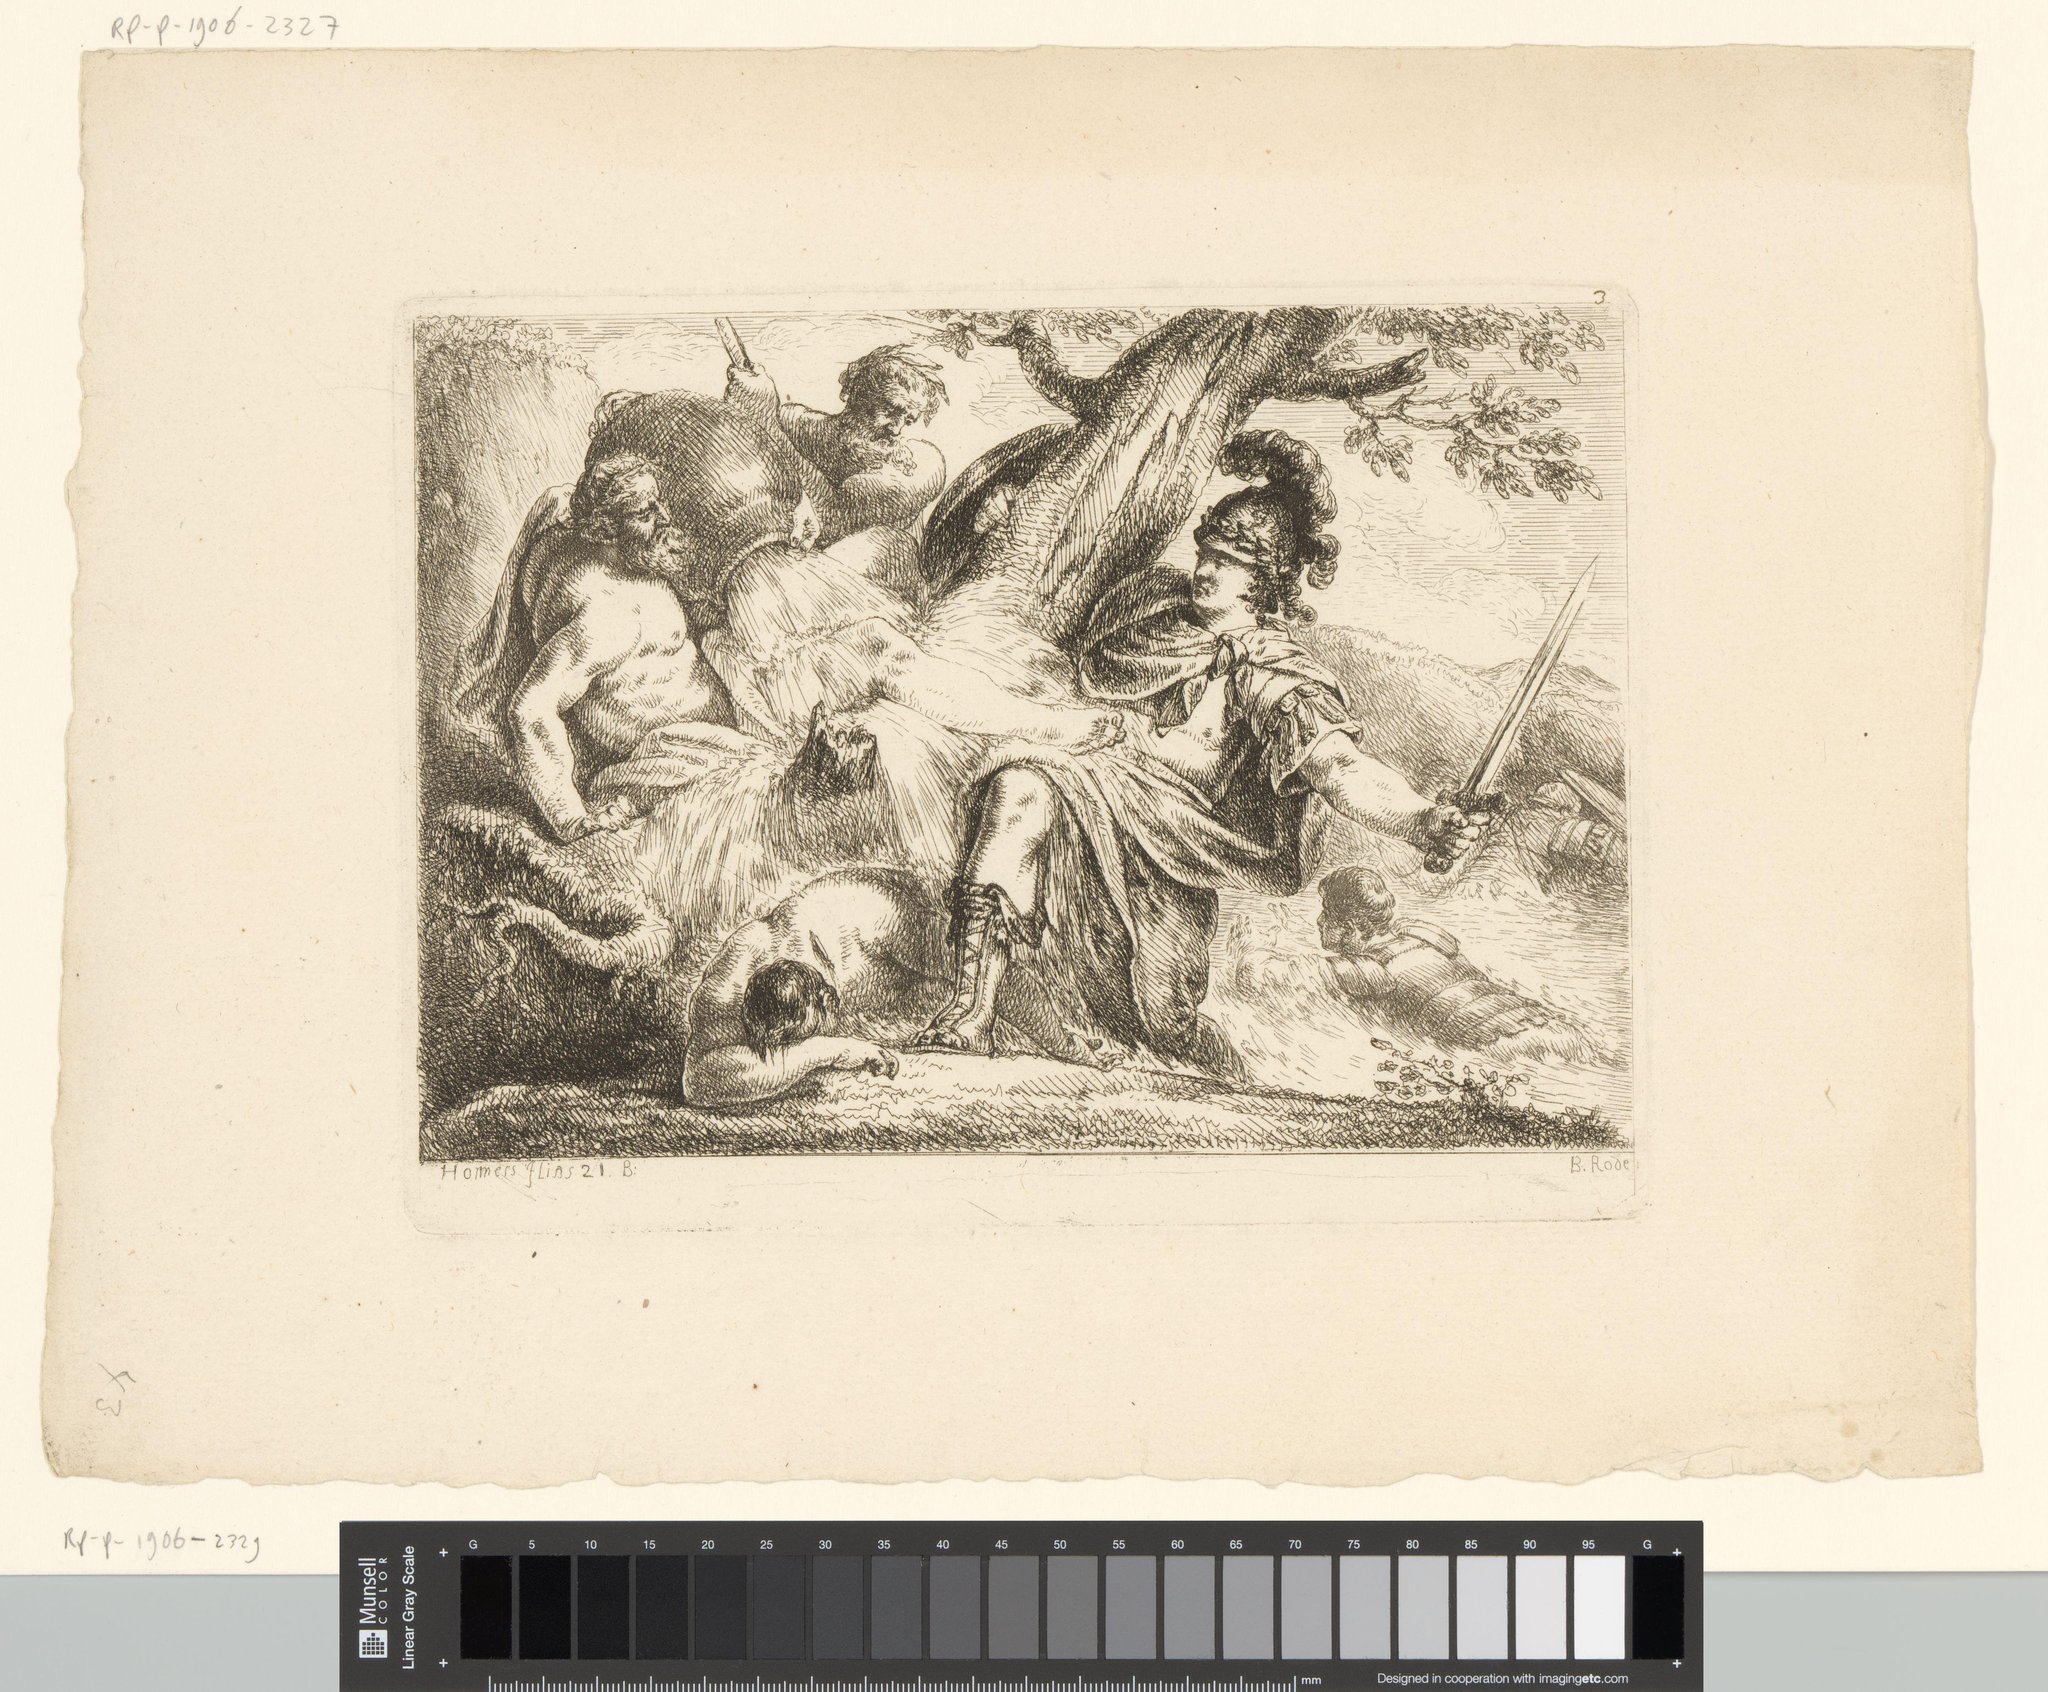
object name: print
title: Achilles bevecht de riviergoden Scamander en Simois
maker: bernhard rode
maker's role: artist, print maker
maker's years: 1725-1797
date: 1768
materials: paper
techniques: etching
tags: achilles fights the river-gods scamander and simois; achilles is assisted by vulcan, who dries up the waters with scorching flames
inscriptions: collector's mark: Lugt 2228